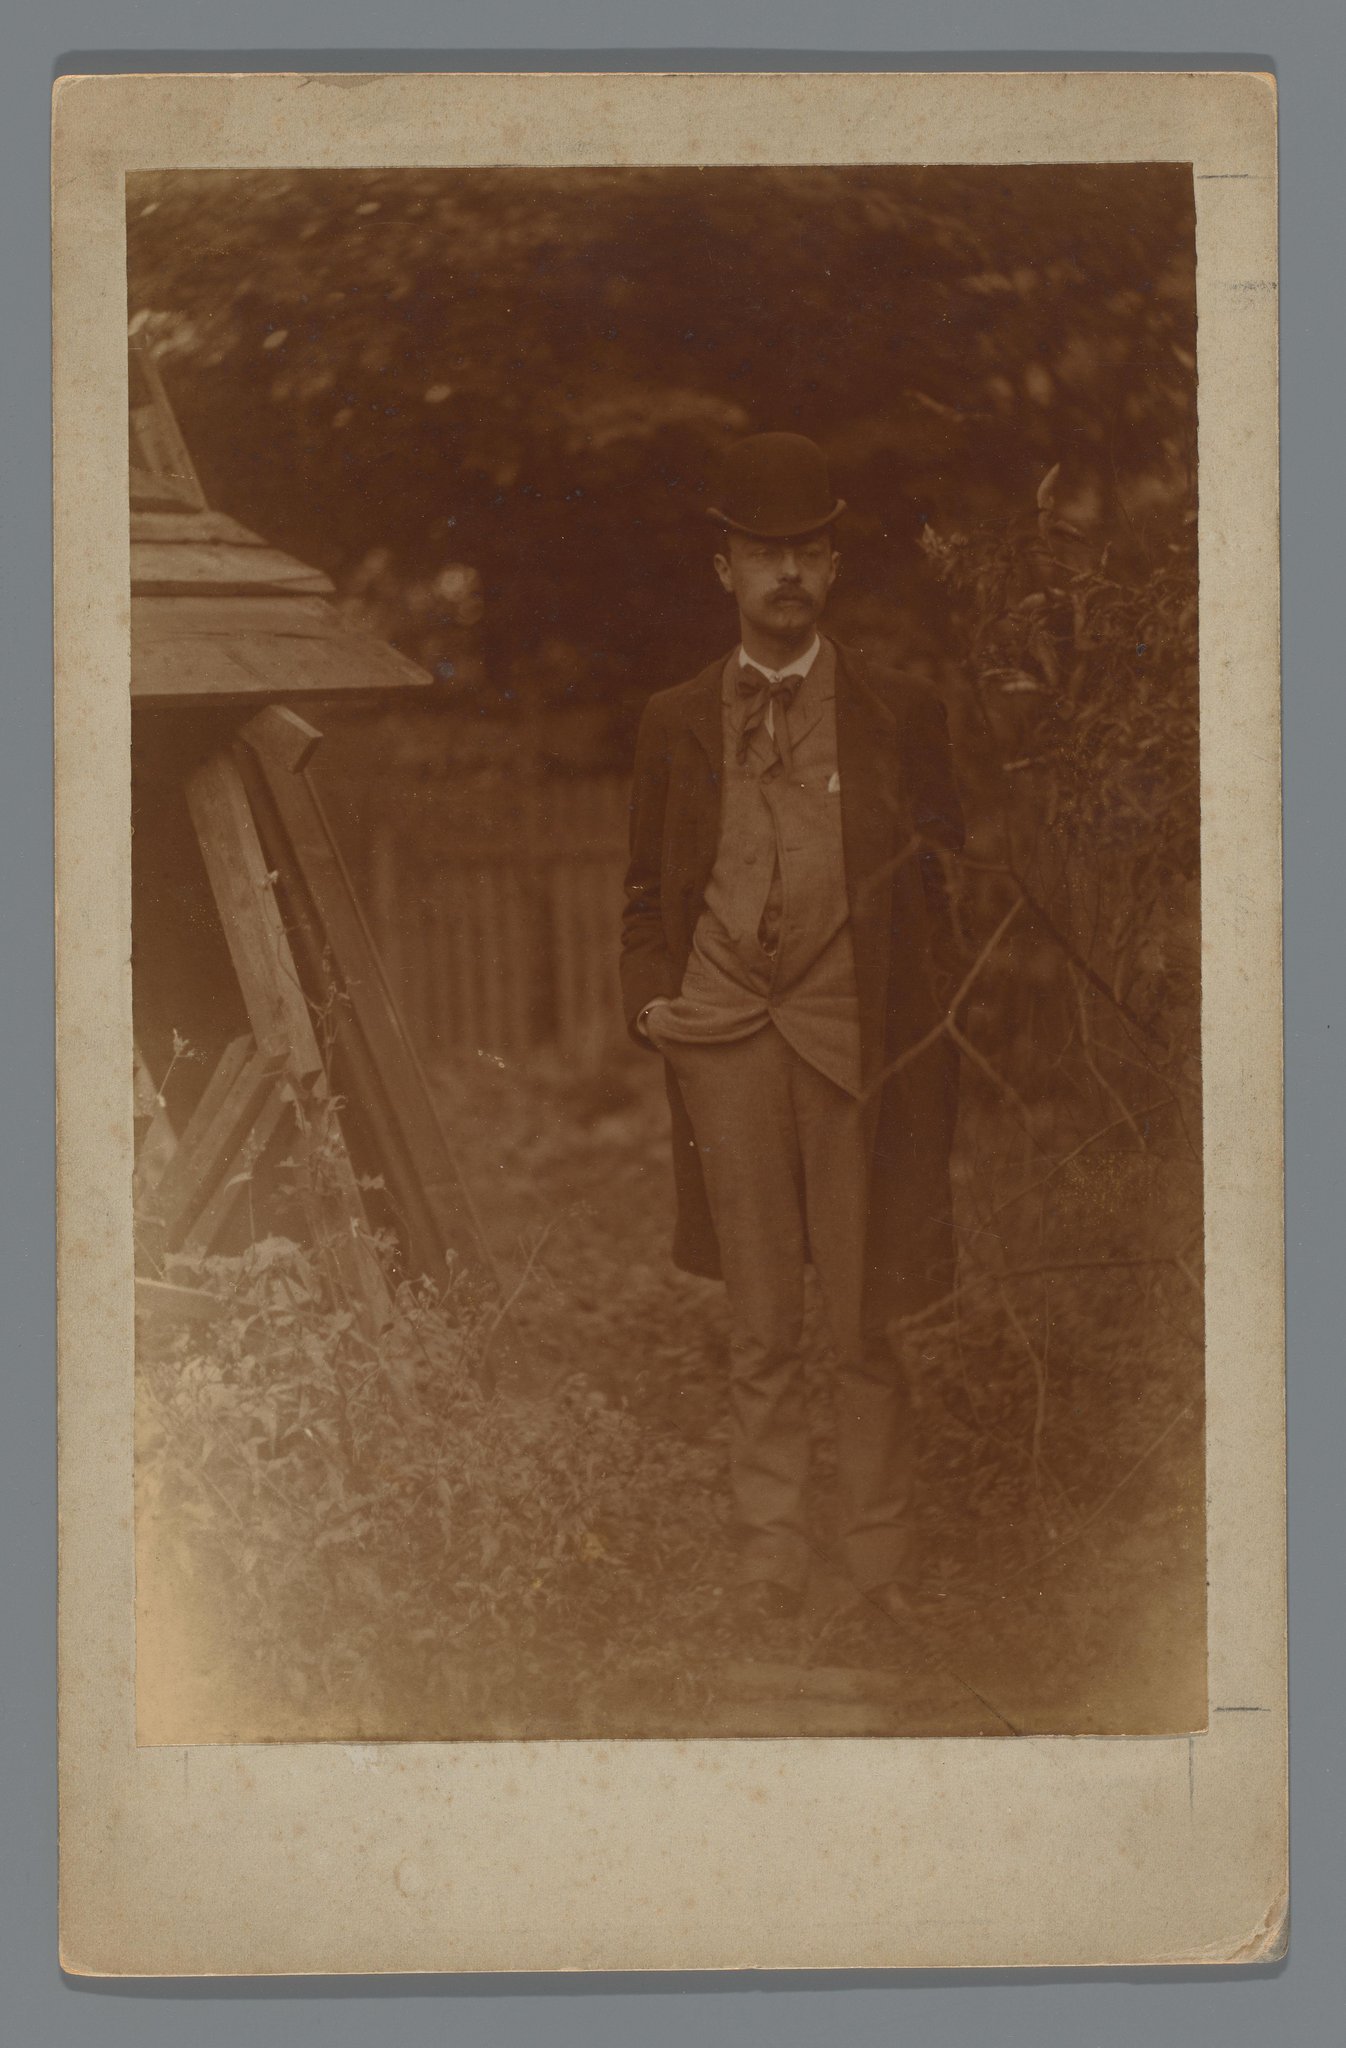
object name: photograph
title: Portret van Alphons Diepenbrock, staand buiten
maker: joseph jessurun de mesquita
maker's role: fotograaf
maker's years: 1865-1890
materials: cardboard, photographic support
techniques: gelatin silver print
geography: amsterdam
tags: amsterdam, alphons diepenbrock, portrait of composer